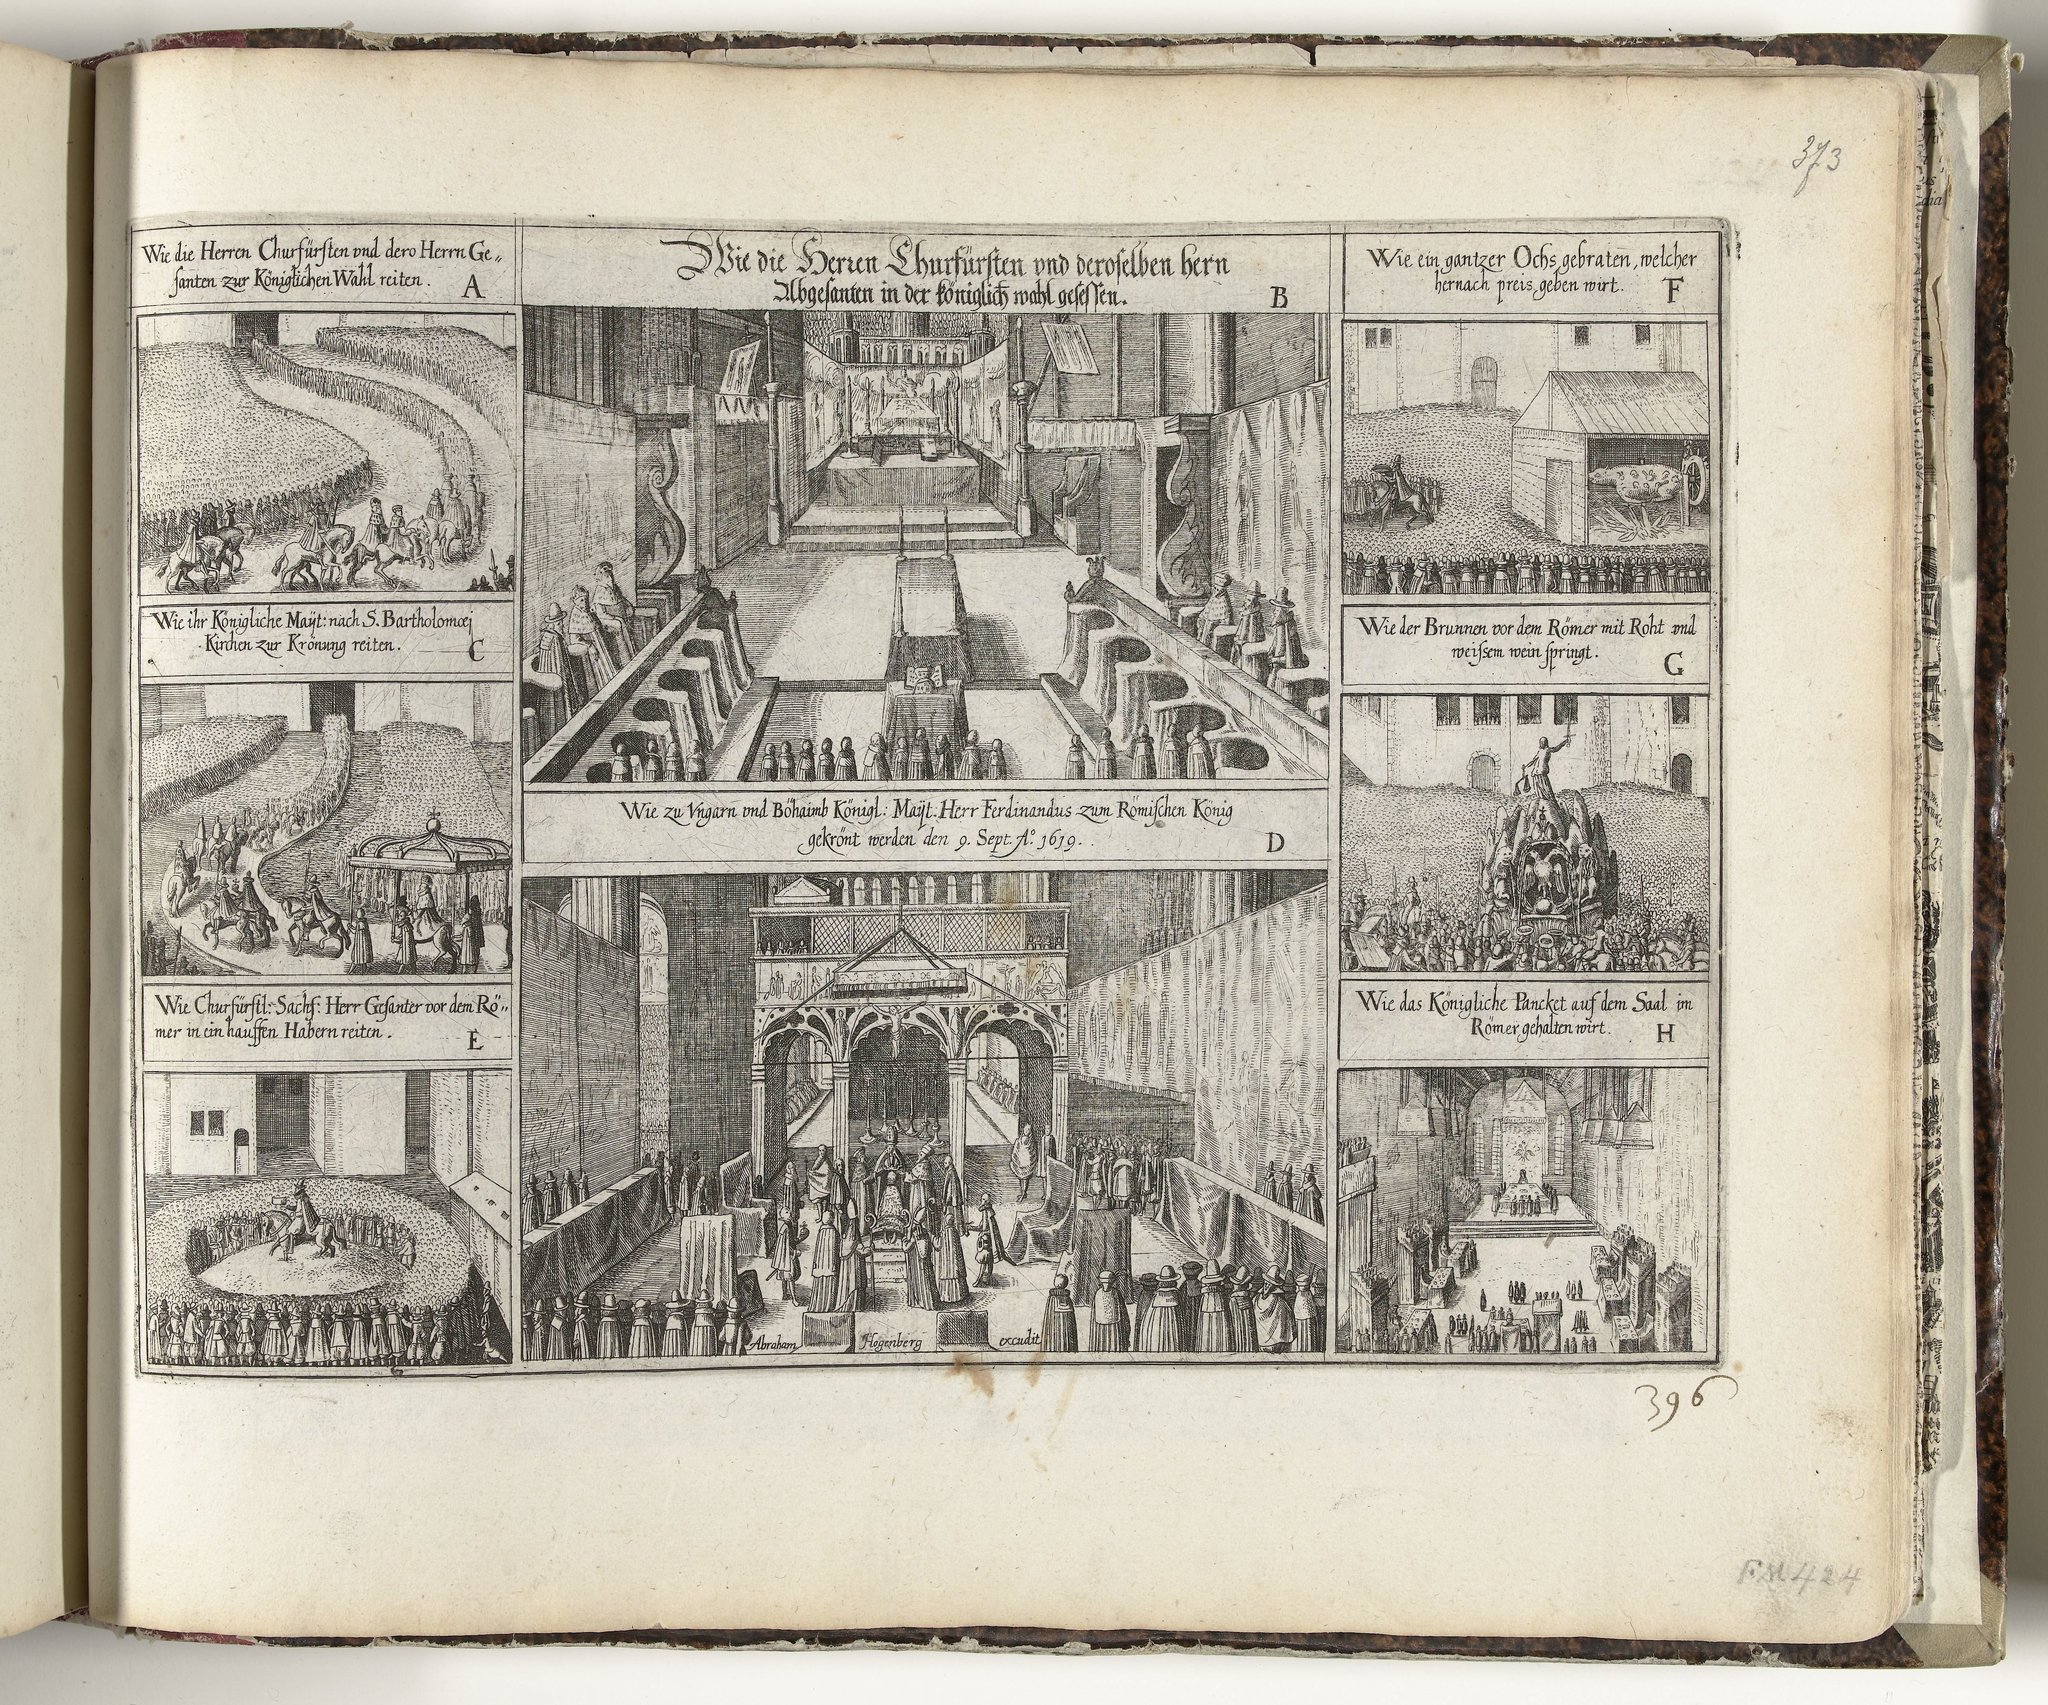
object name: print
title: Ferdinand II tot Rooms koning gekroond, 1619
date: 1619-1621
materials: paper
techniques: etching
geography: cologne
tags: vienna, ferdinand ii (duits keizer), public festivities at other royal events, not meant or mentioned above, coronation of a ruler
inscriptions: inscription: ‘396’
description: Kroning van Ferdinand II tot Rooms koning, 9 september 1619. In acht aparte voorstellingen A-H. Zonder onderschrift, elke voorstelling met een opschrift van 2 regels in het Duits. Rechtsonder met pen genummerd: 396. De prent maakt deel uit van een album.